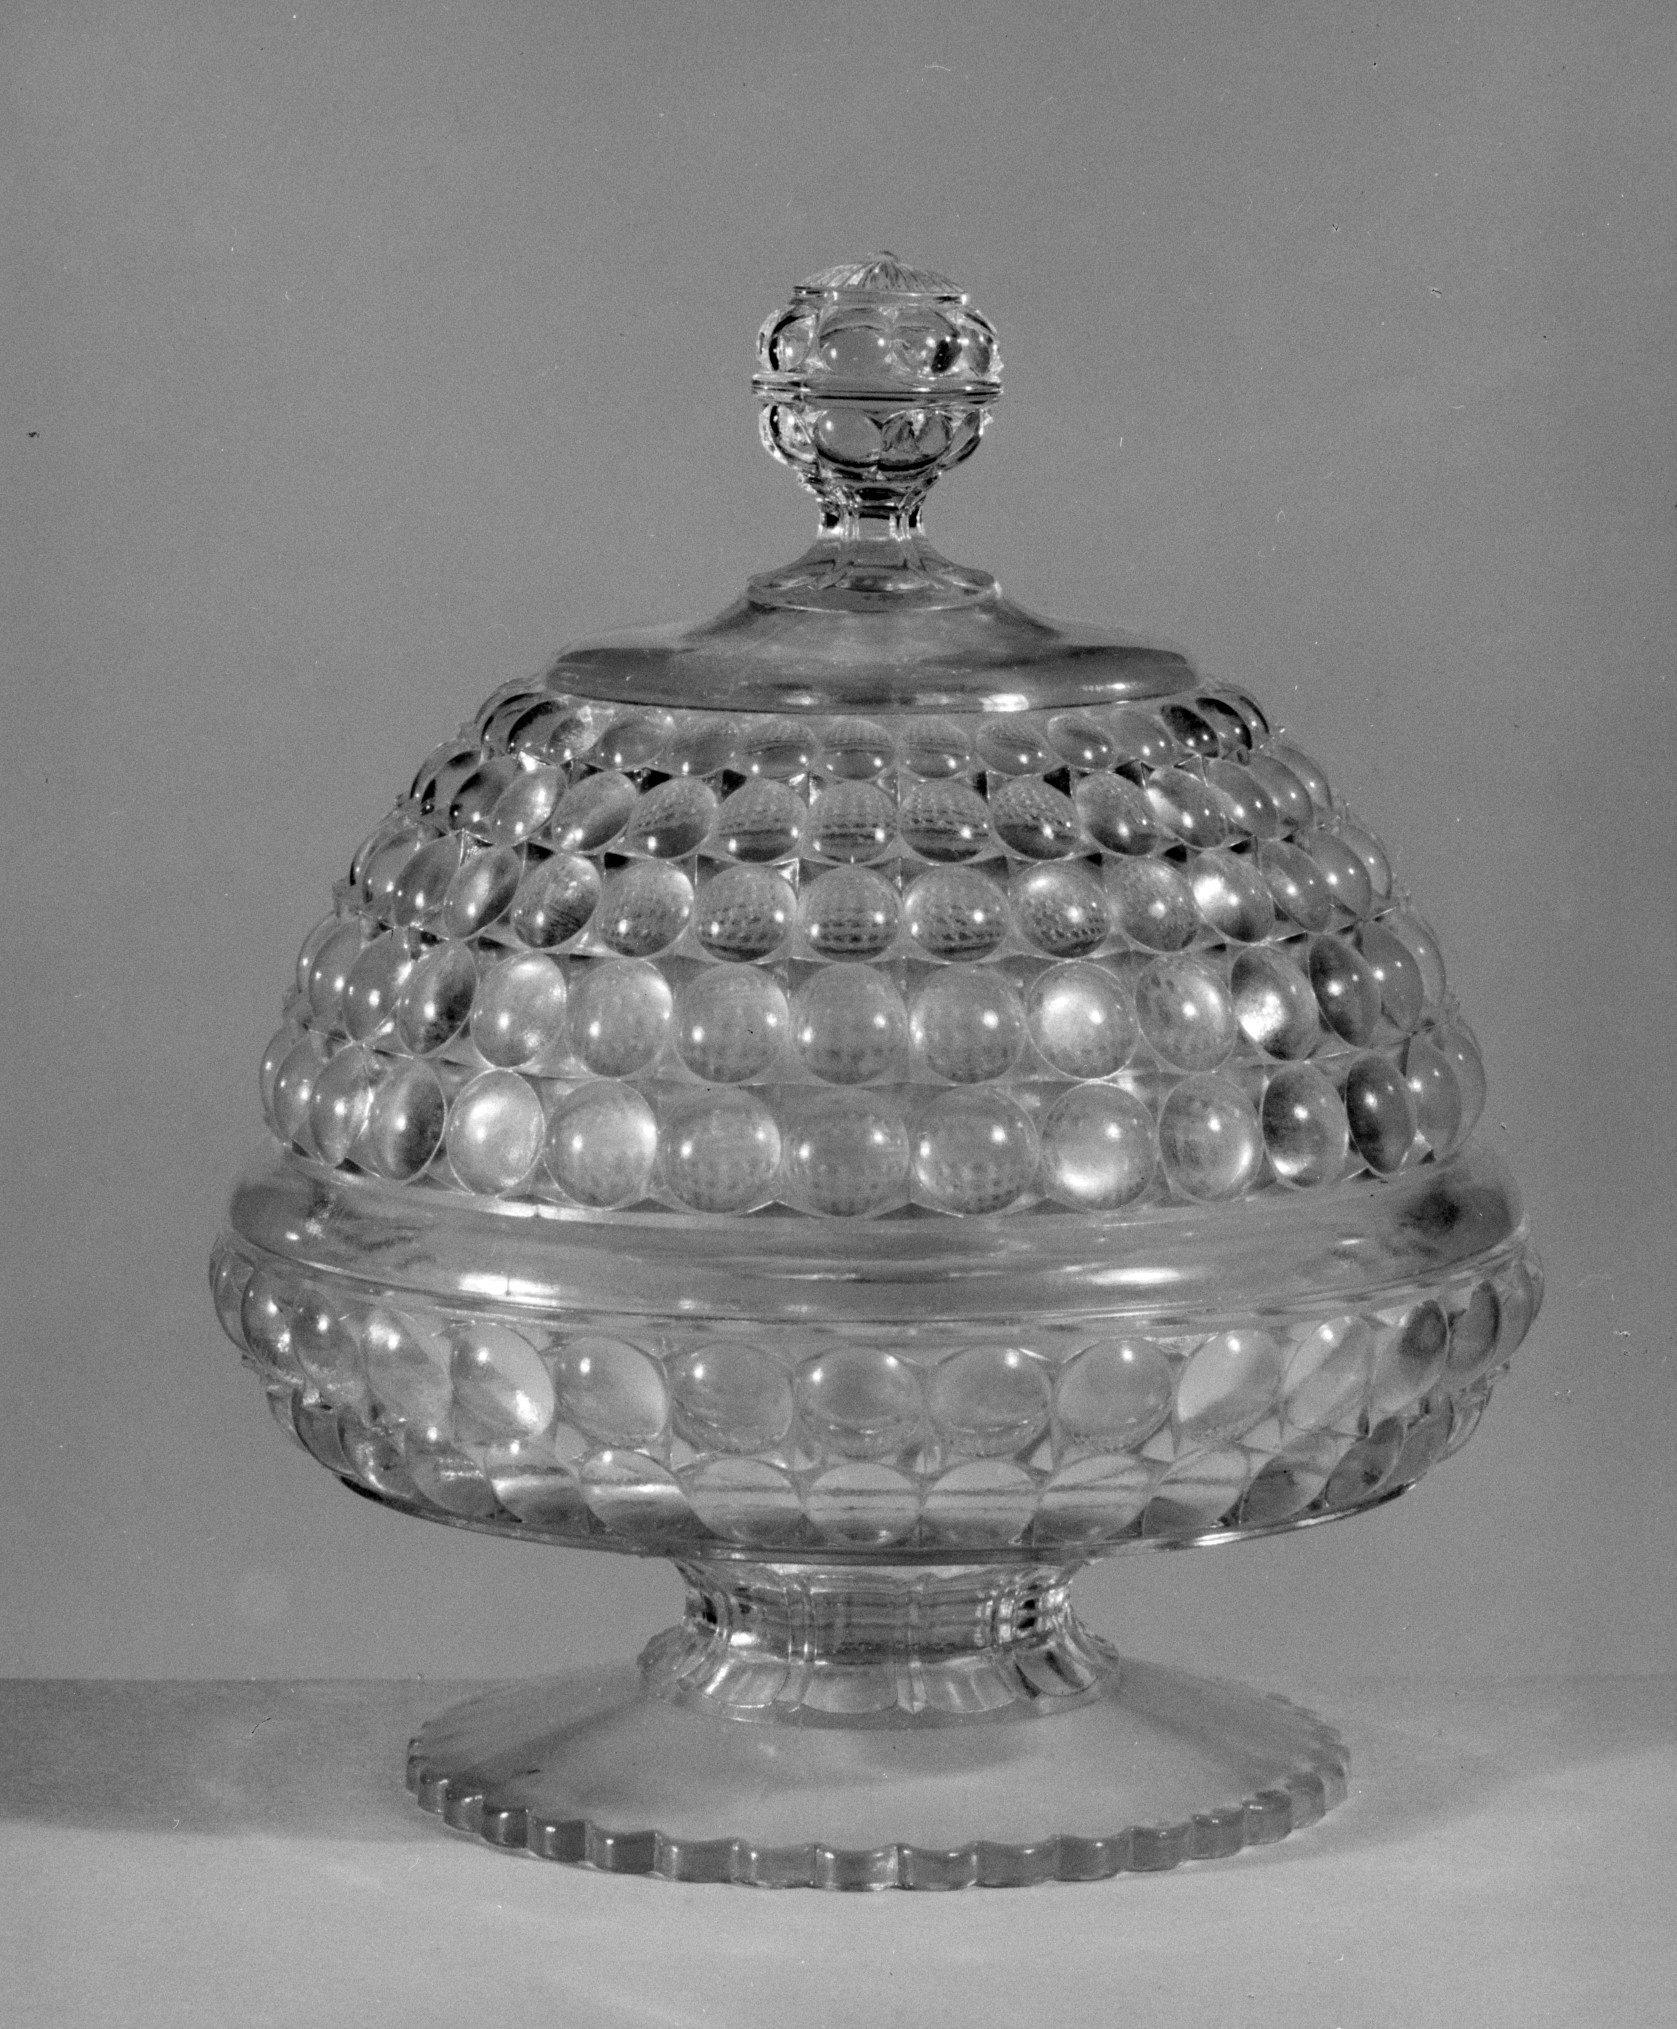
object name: butter dish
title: Covered Butter Dish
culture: american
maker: richards and hartley flint glass co.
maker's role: maker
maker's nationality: american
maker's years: 1867-1890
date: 1888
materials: glass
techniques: pressed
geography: united states